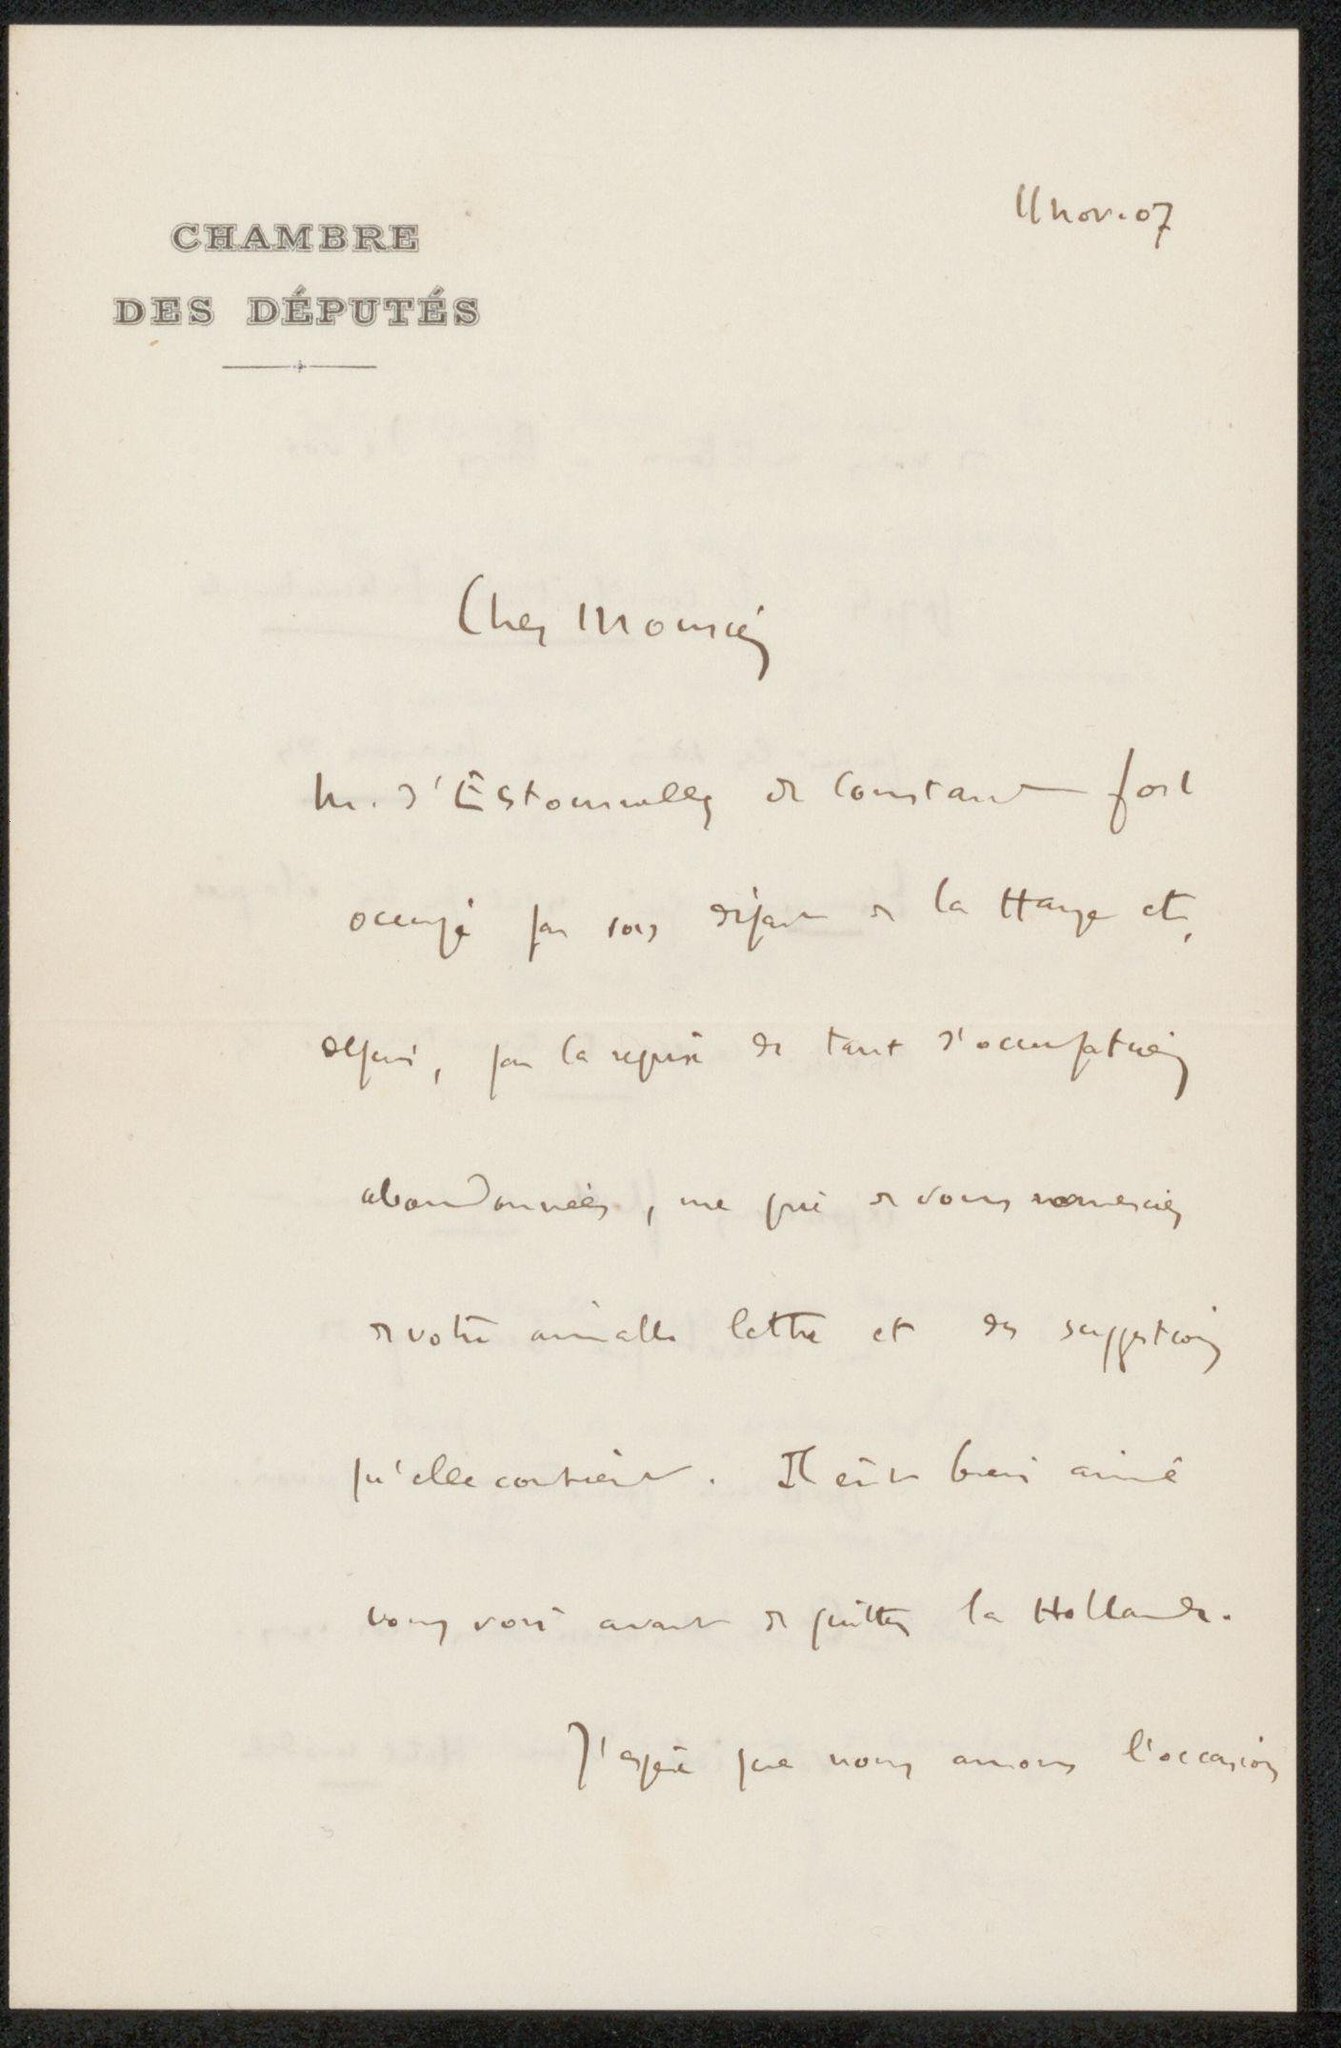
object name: letter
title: Brief aan Philip Zilcken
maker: jules rais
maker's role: journalist, kunstcriticus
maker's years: 1872-1943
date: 1907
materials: ink, paper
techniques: pen, printing, writing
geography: paris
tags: the hague, painter, philip zilcken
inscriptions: collector's mark: ‘RPK’